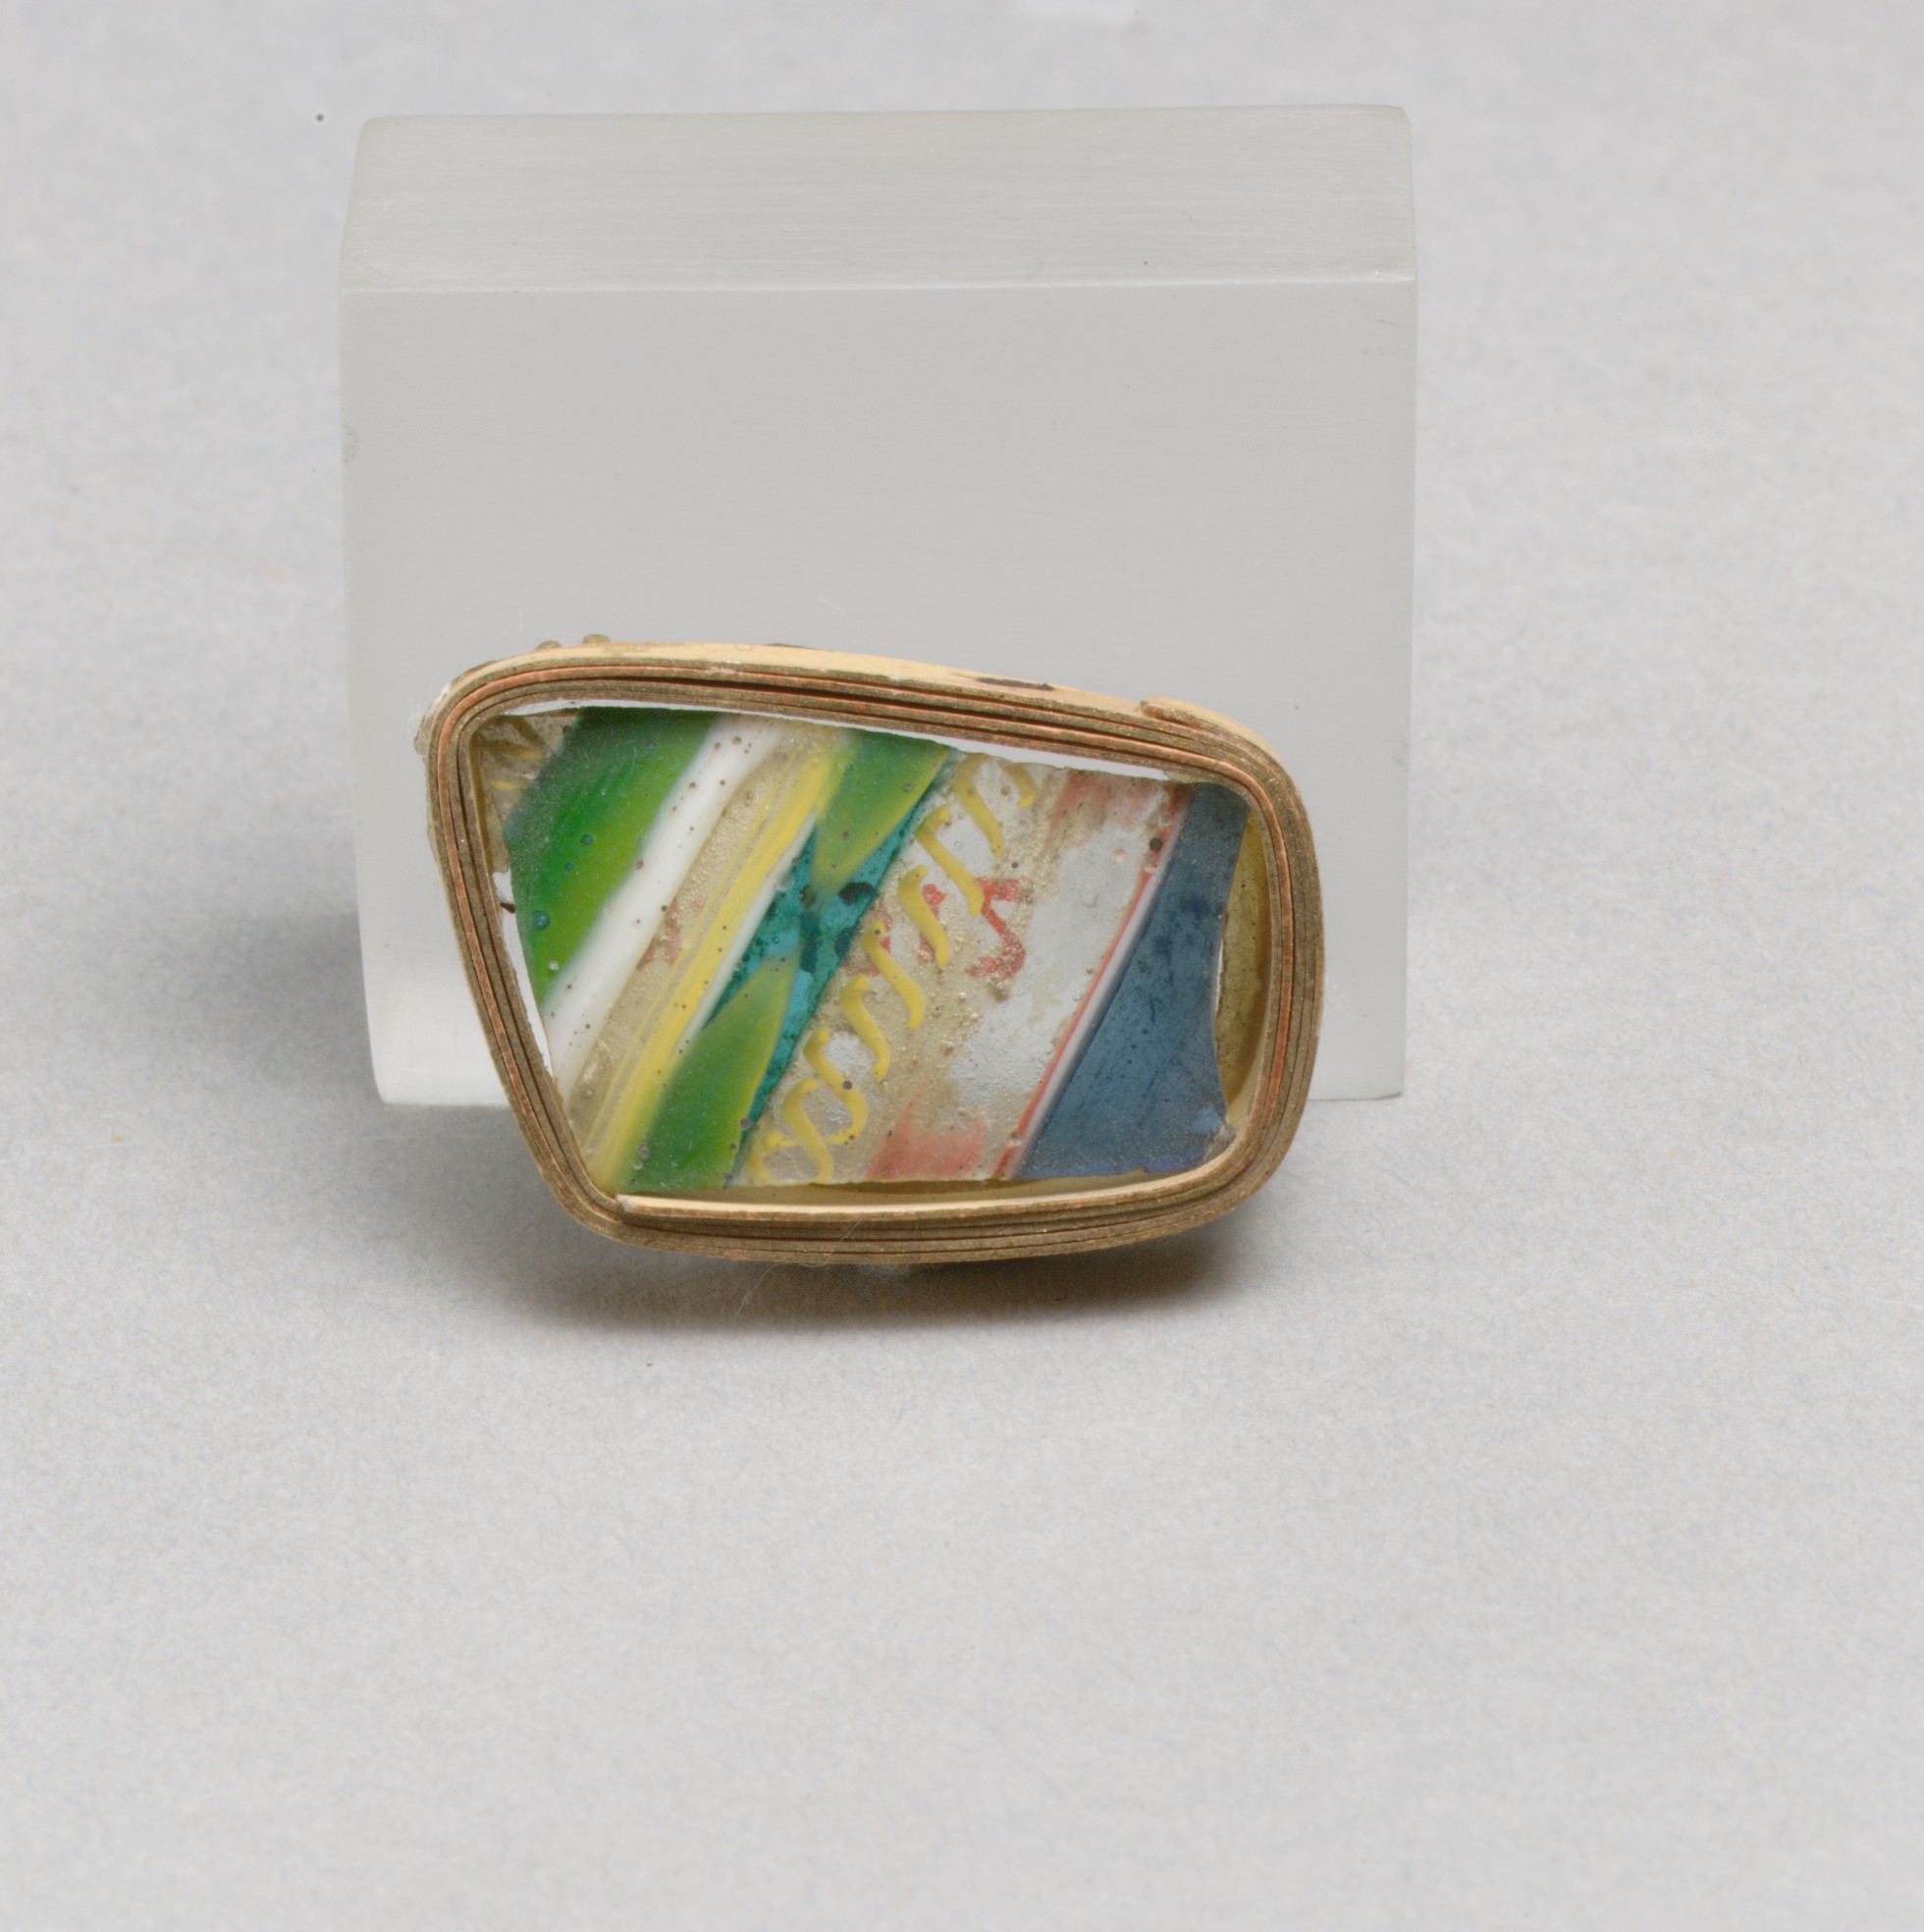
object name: fragment, striped mosaic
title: Glass striped mosaic fragment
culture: roman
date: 34 BCE-33 CE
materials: glass